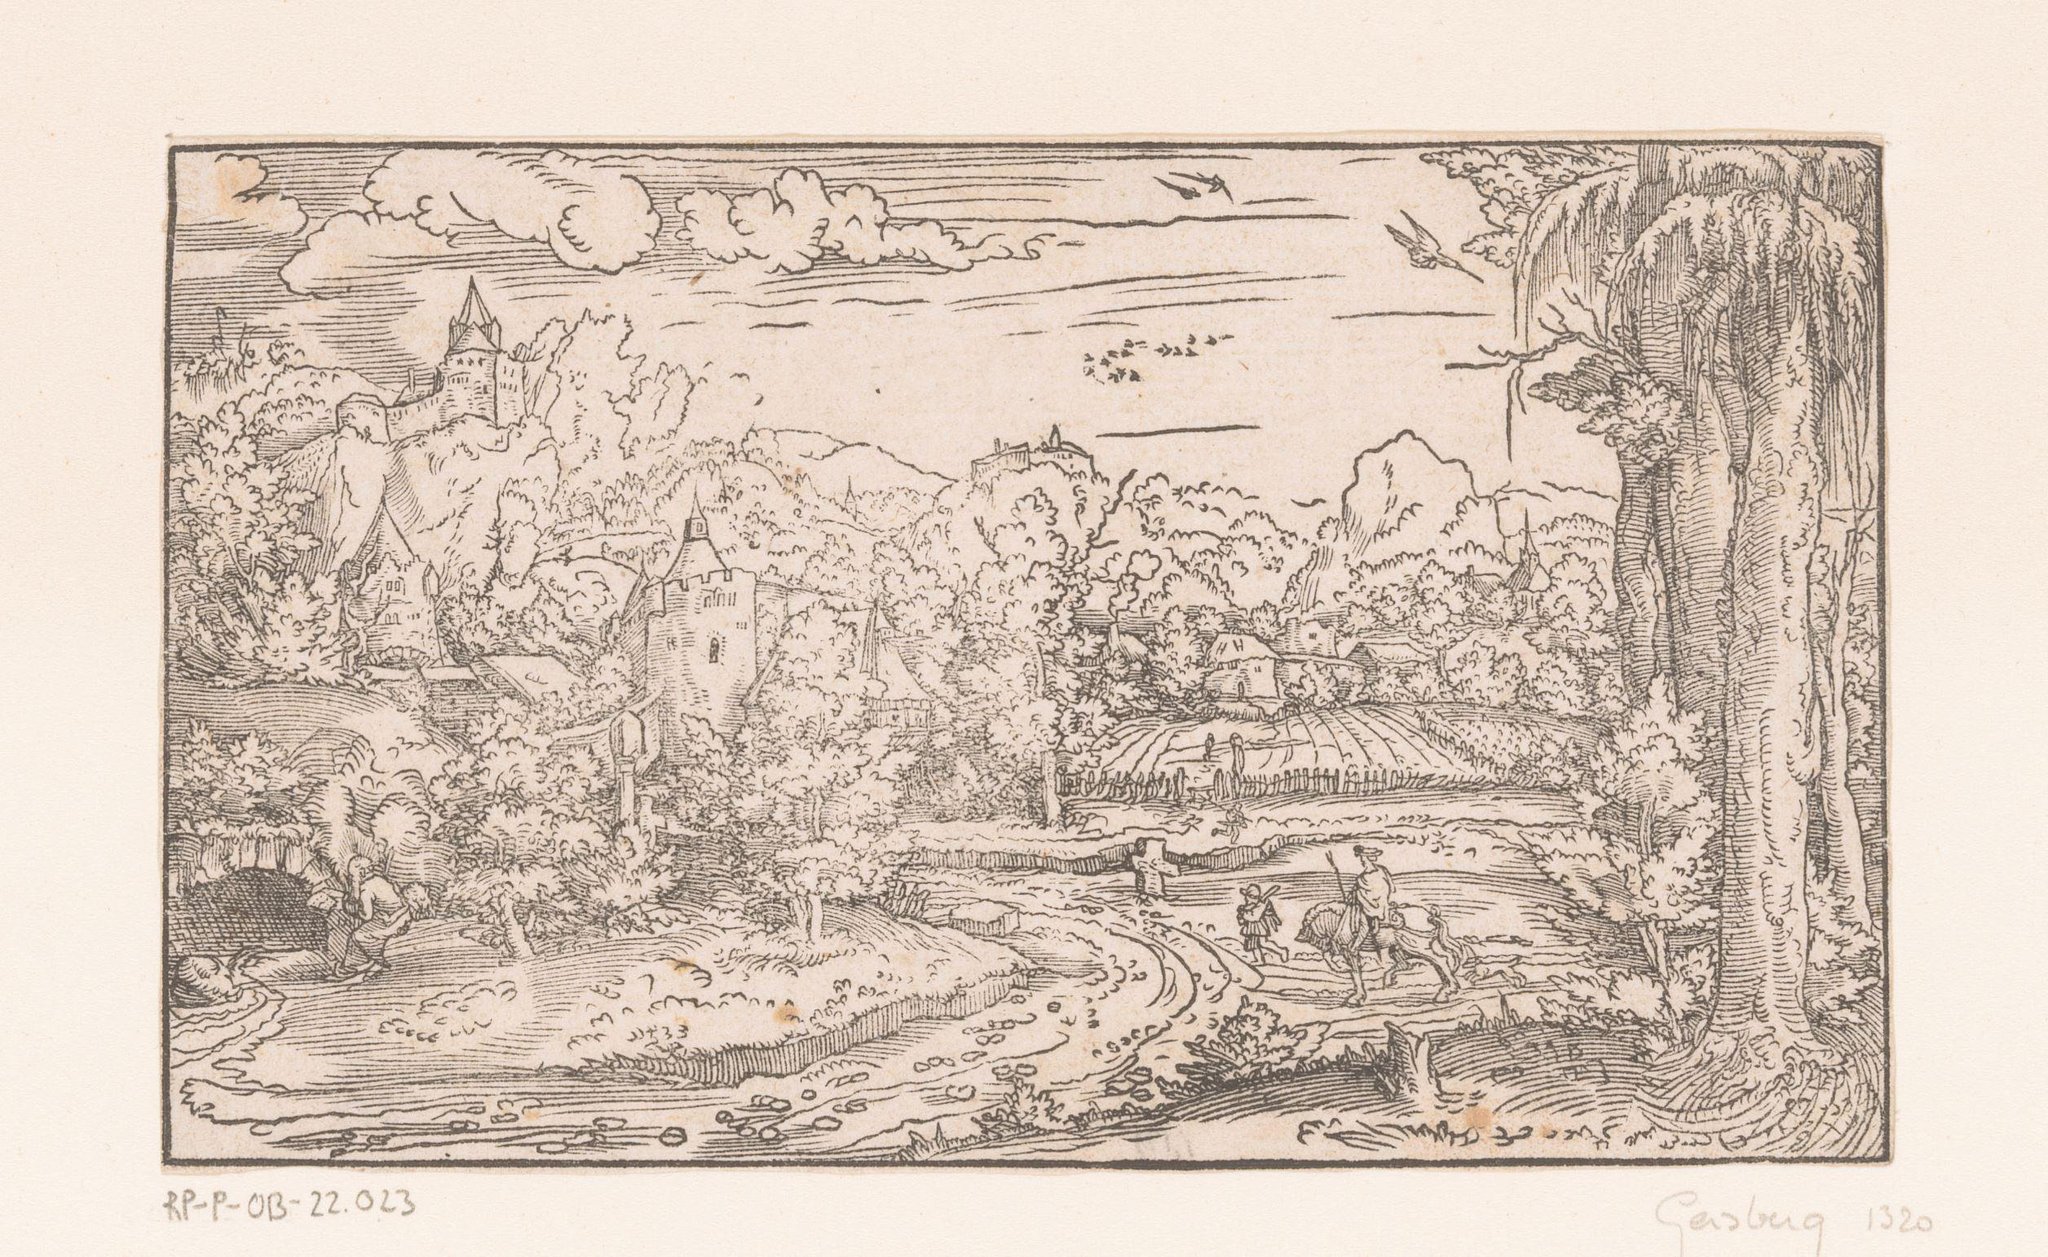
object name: print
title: Landschappen met figuren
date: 1524-1562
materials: paper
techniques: woodcut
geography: nuremberg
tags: riding a horse, ass, or mule; rider, horseman, the monk and hermit jerome (hieronymus); possible attributes: book, cardinal's hat, crucifix, hour-glass, lion, skull, stone, 'en route', traveller under way, landscapes (+ landscape with figures, staffage)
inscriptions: number: ‘189’